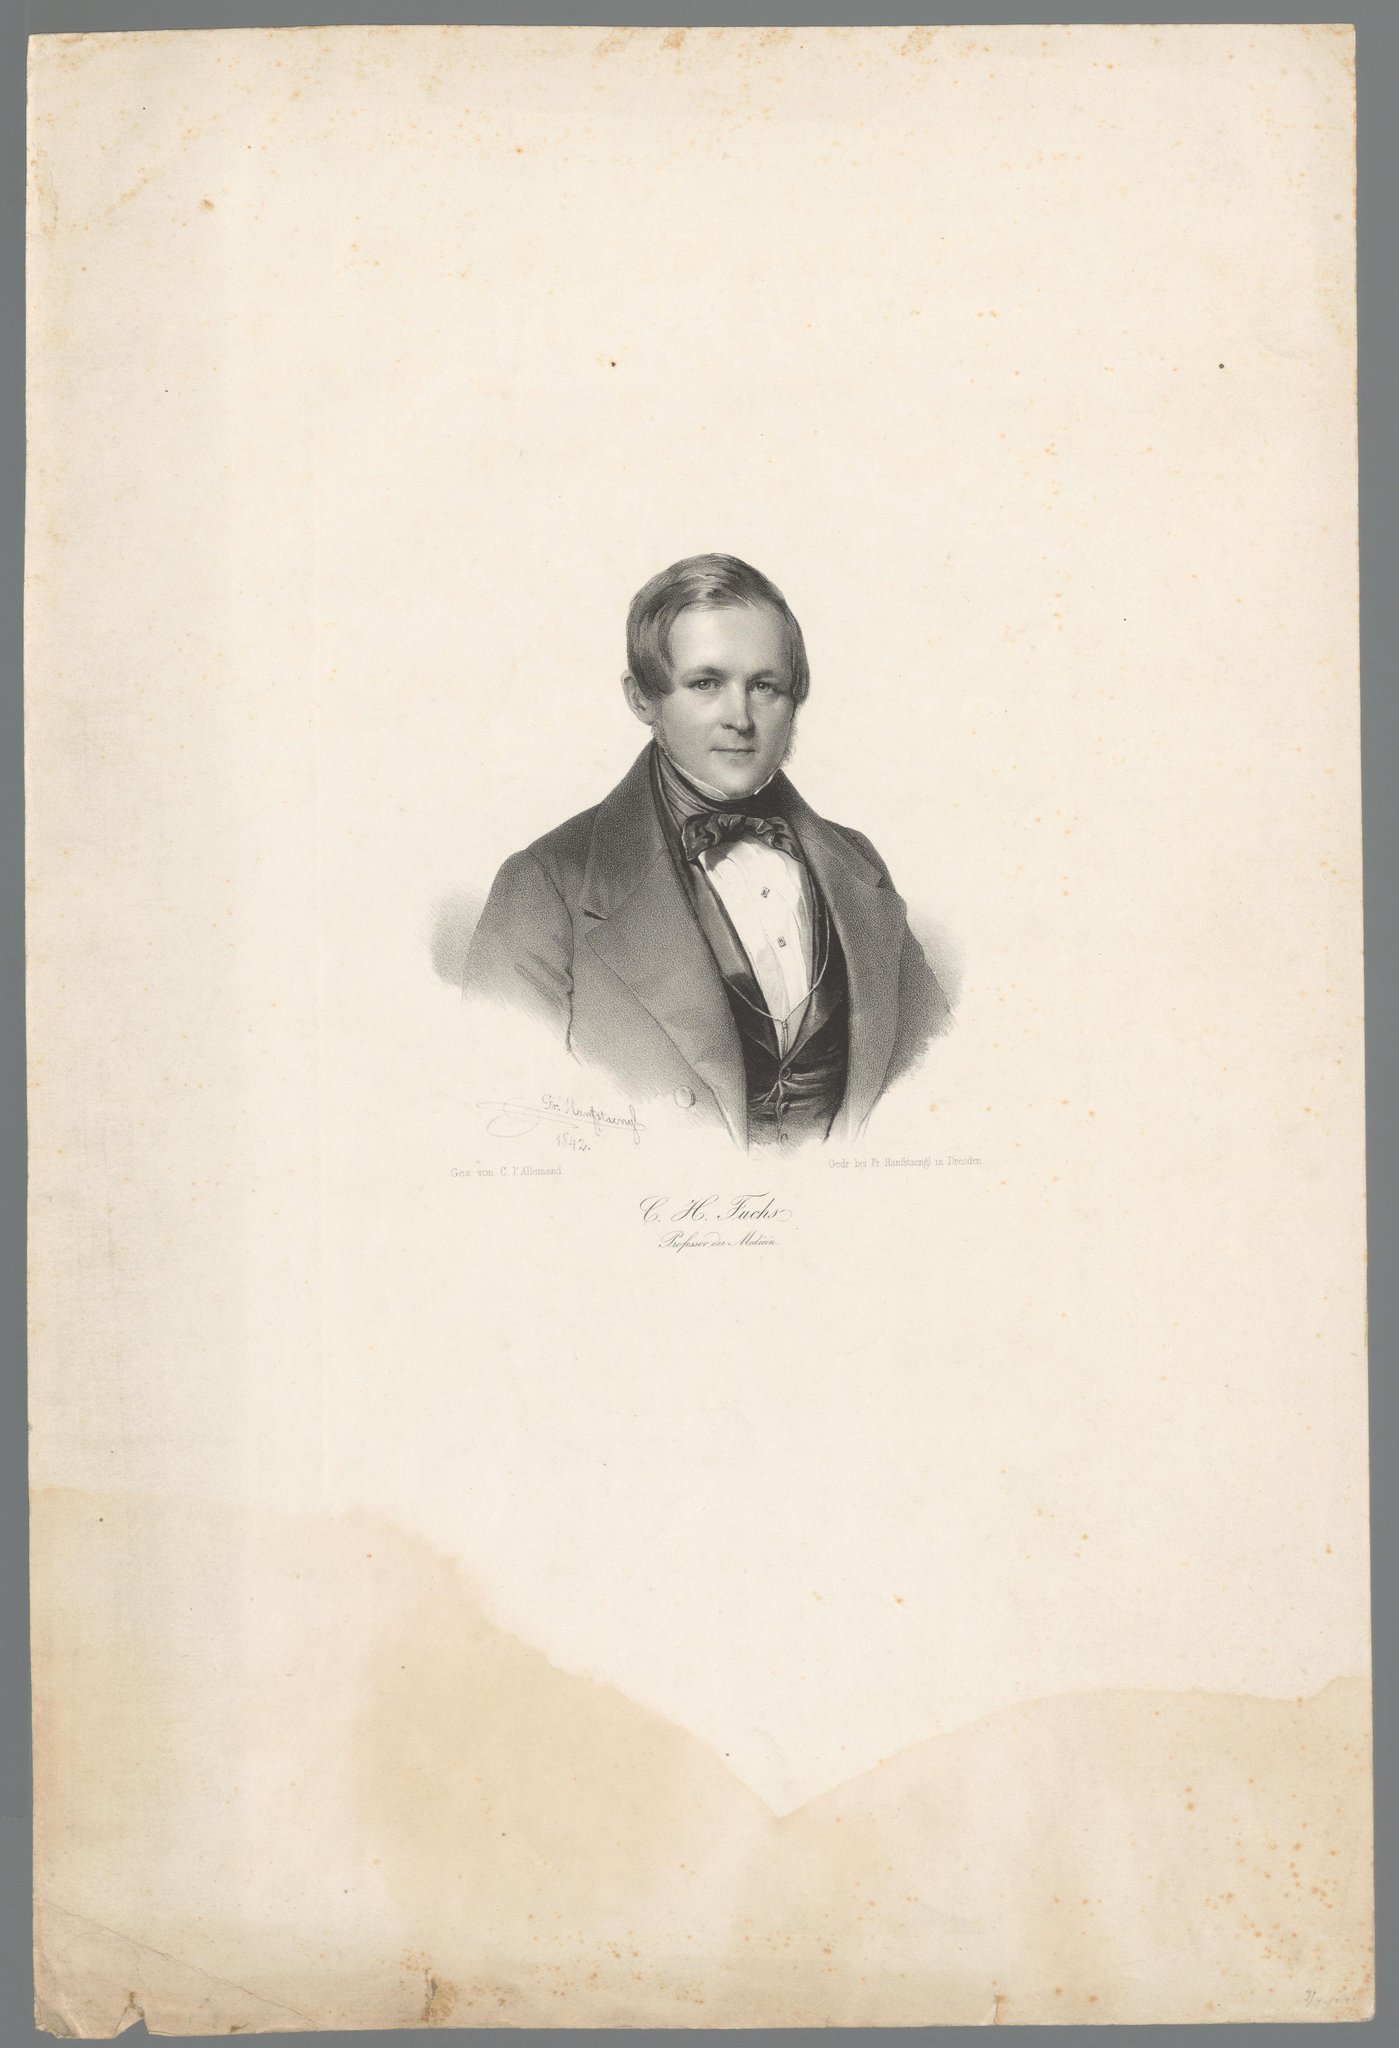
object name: print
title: C.H. Fuchs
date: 1842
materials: paper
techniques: lithograph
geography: dresden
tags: adult man, historical persons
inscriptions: collector's mark: Lugt 2228